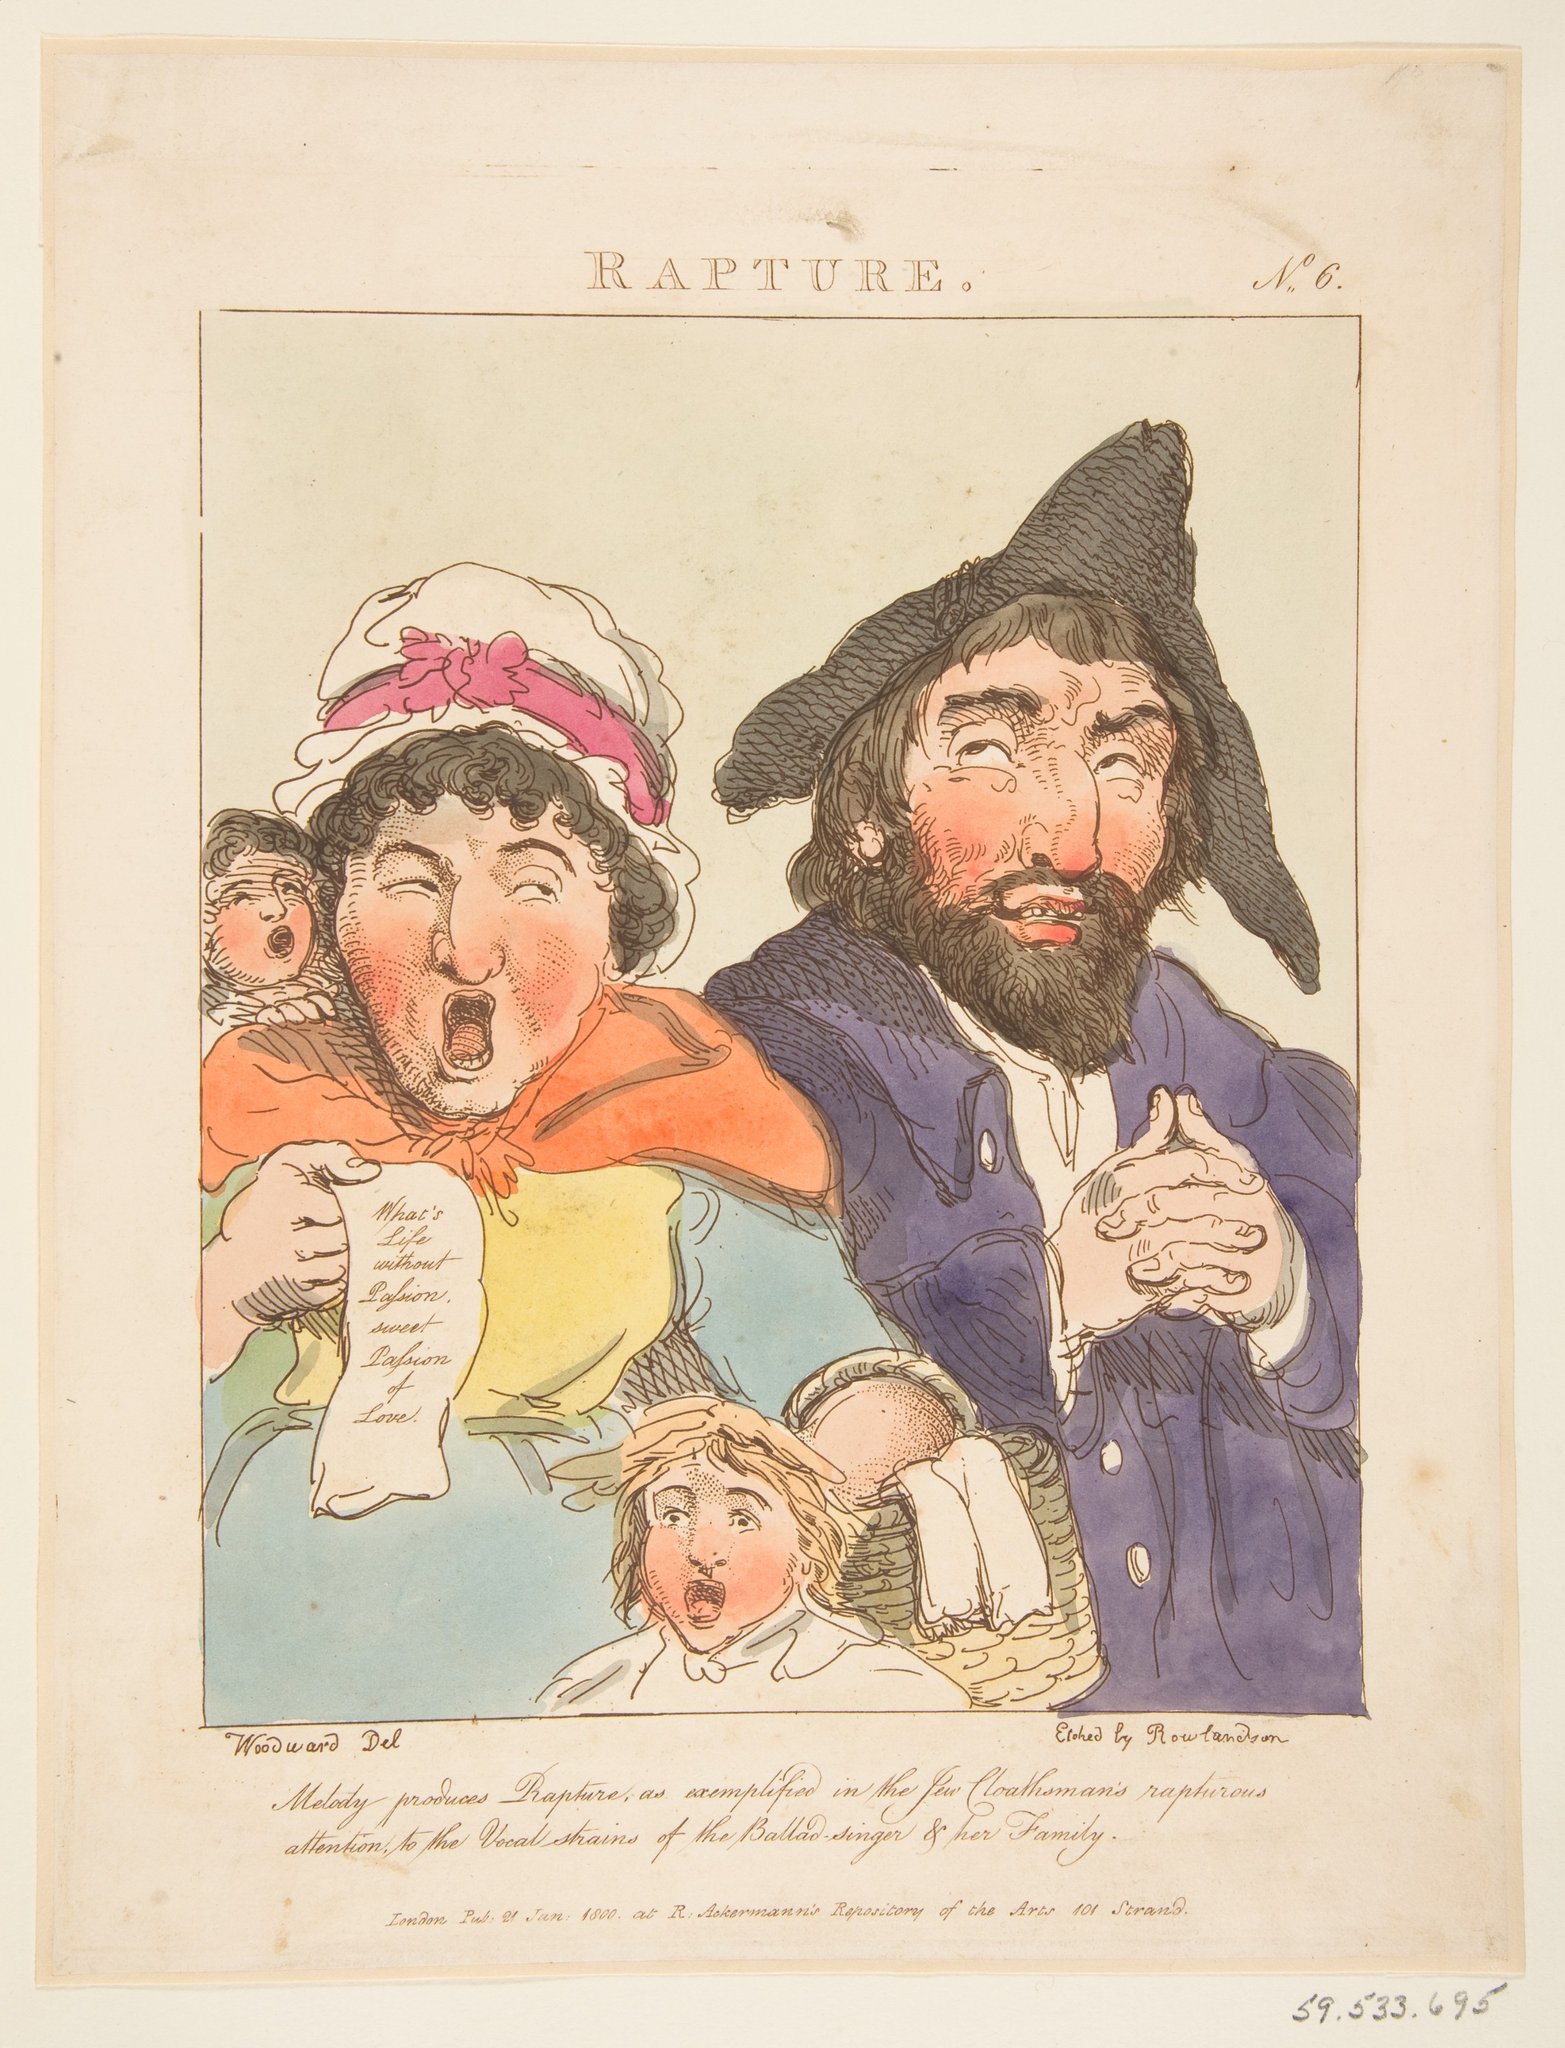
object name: print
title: Rapture (Le Brun Travested, or Caricatures of the Passions)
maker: thomas rowlandson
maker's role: artist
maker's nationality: british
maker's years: 1757-1827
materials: ink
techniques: etching, printing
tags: satire,children,men,women